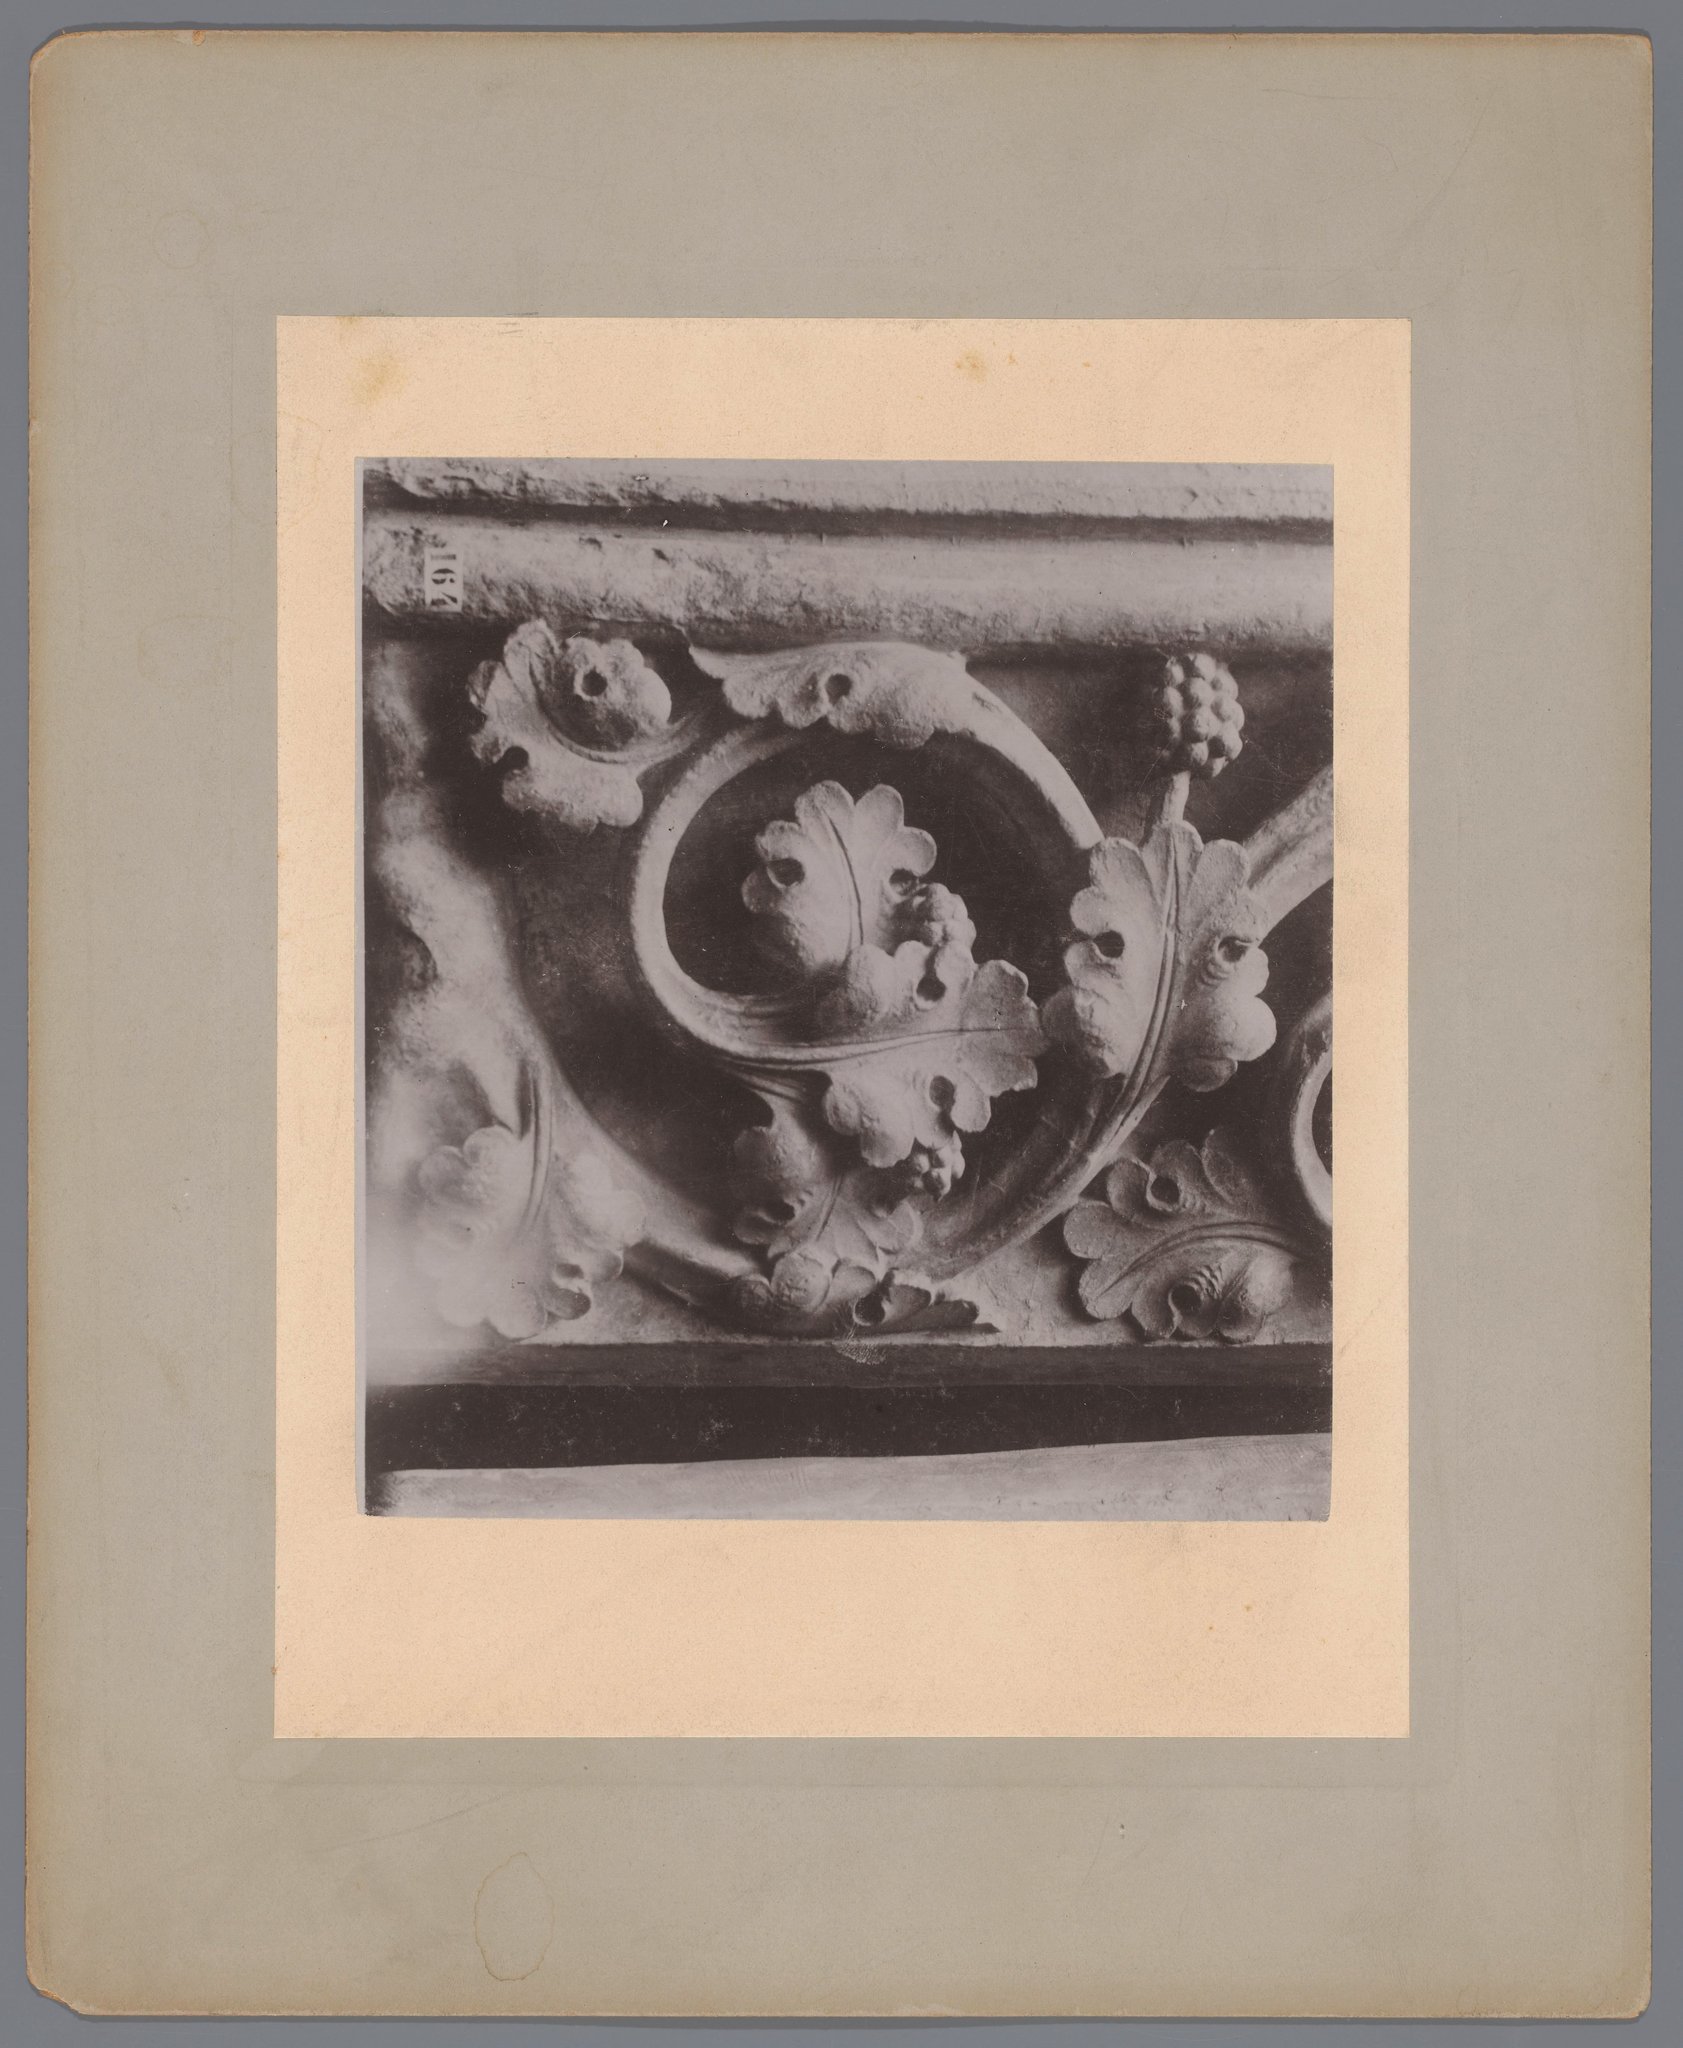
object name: photograph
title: Afgietsel van een detail van een archivolt versierd met rankwerk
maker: Anonymous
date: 1880-1940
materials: paper, cardboard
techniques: collodion silver print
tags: arch, archivolt ~ architecture, trees: oak (+ leaves, putting forth leaves)